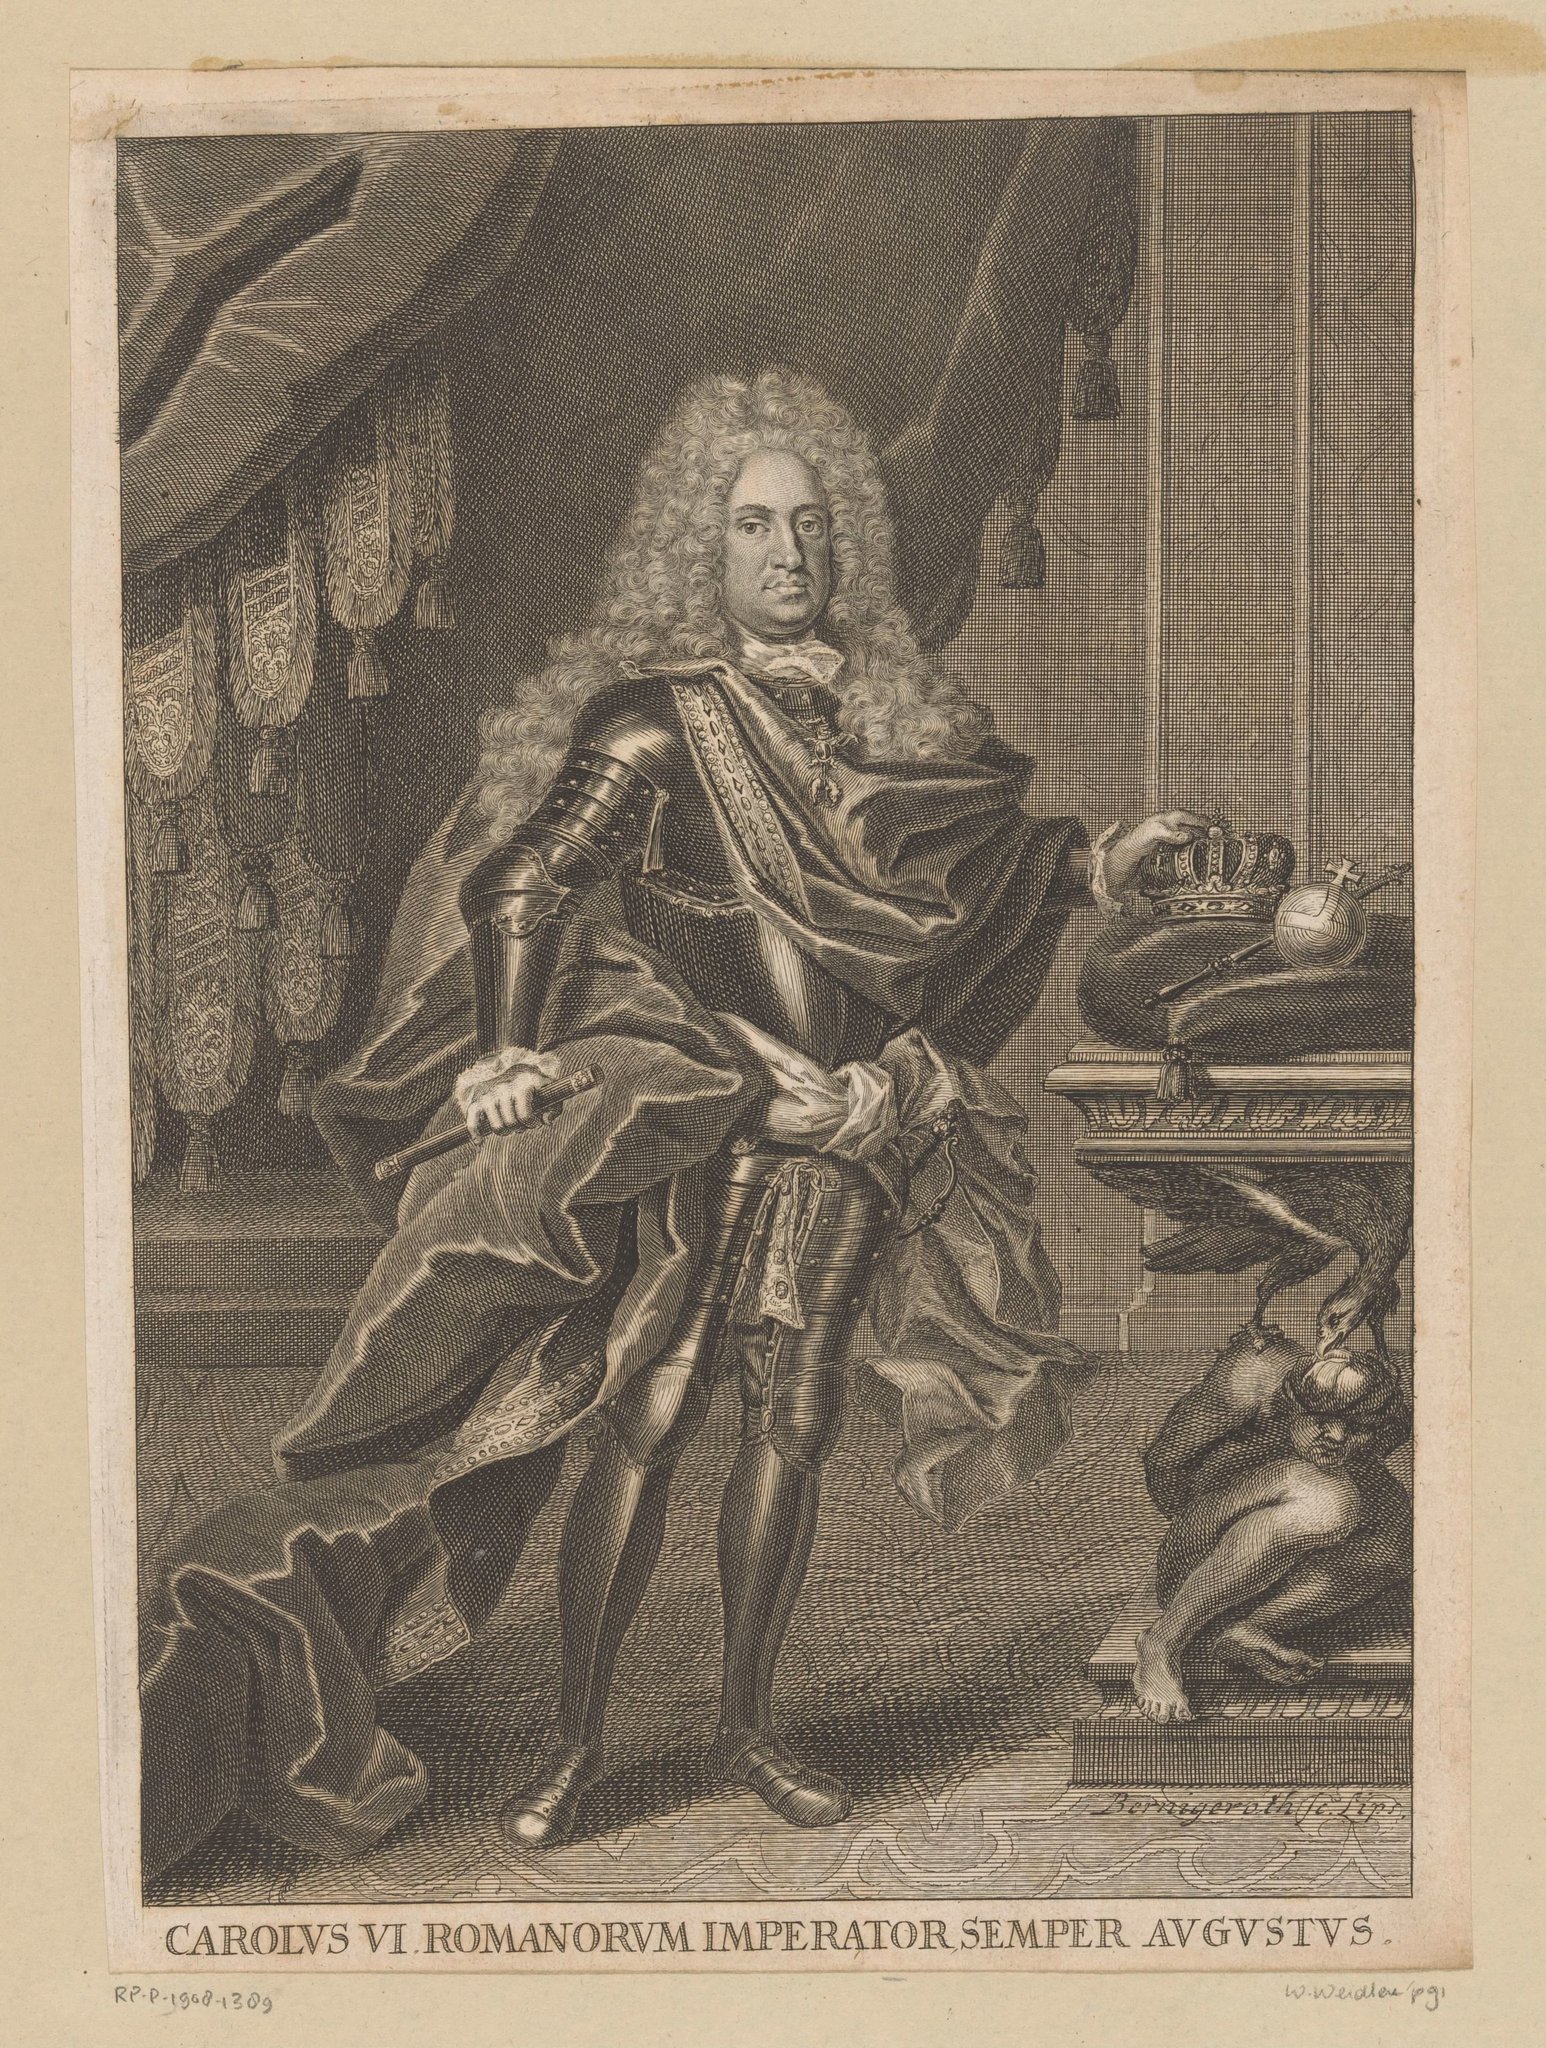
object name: print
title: Portret van keizer Karel VI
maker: martin bernigeroth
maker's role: print maker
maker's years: 1670-1733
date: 1711-1733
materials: paper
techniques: engraving, etching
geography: leipzig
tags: vienna, charles vi (holy roman emperor), armour, historical persons, baton of general, insignia and symbols of sovereignty (crown, diadem, sceptre, orb, seal, standard, cloak, pectoral)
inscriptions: collector's mark: Lugt 2228